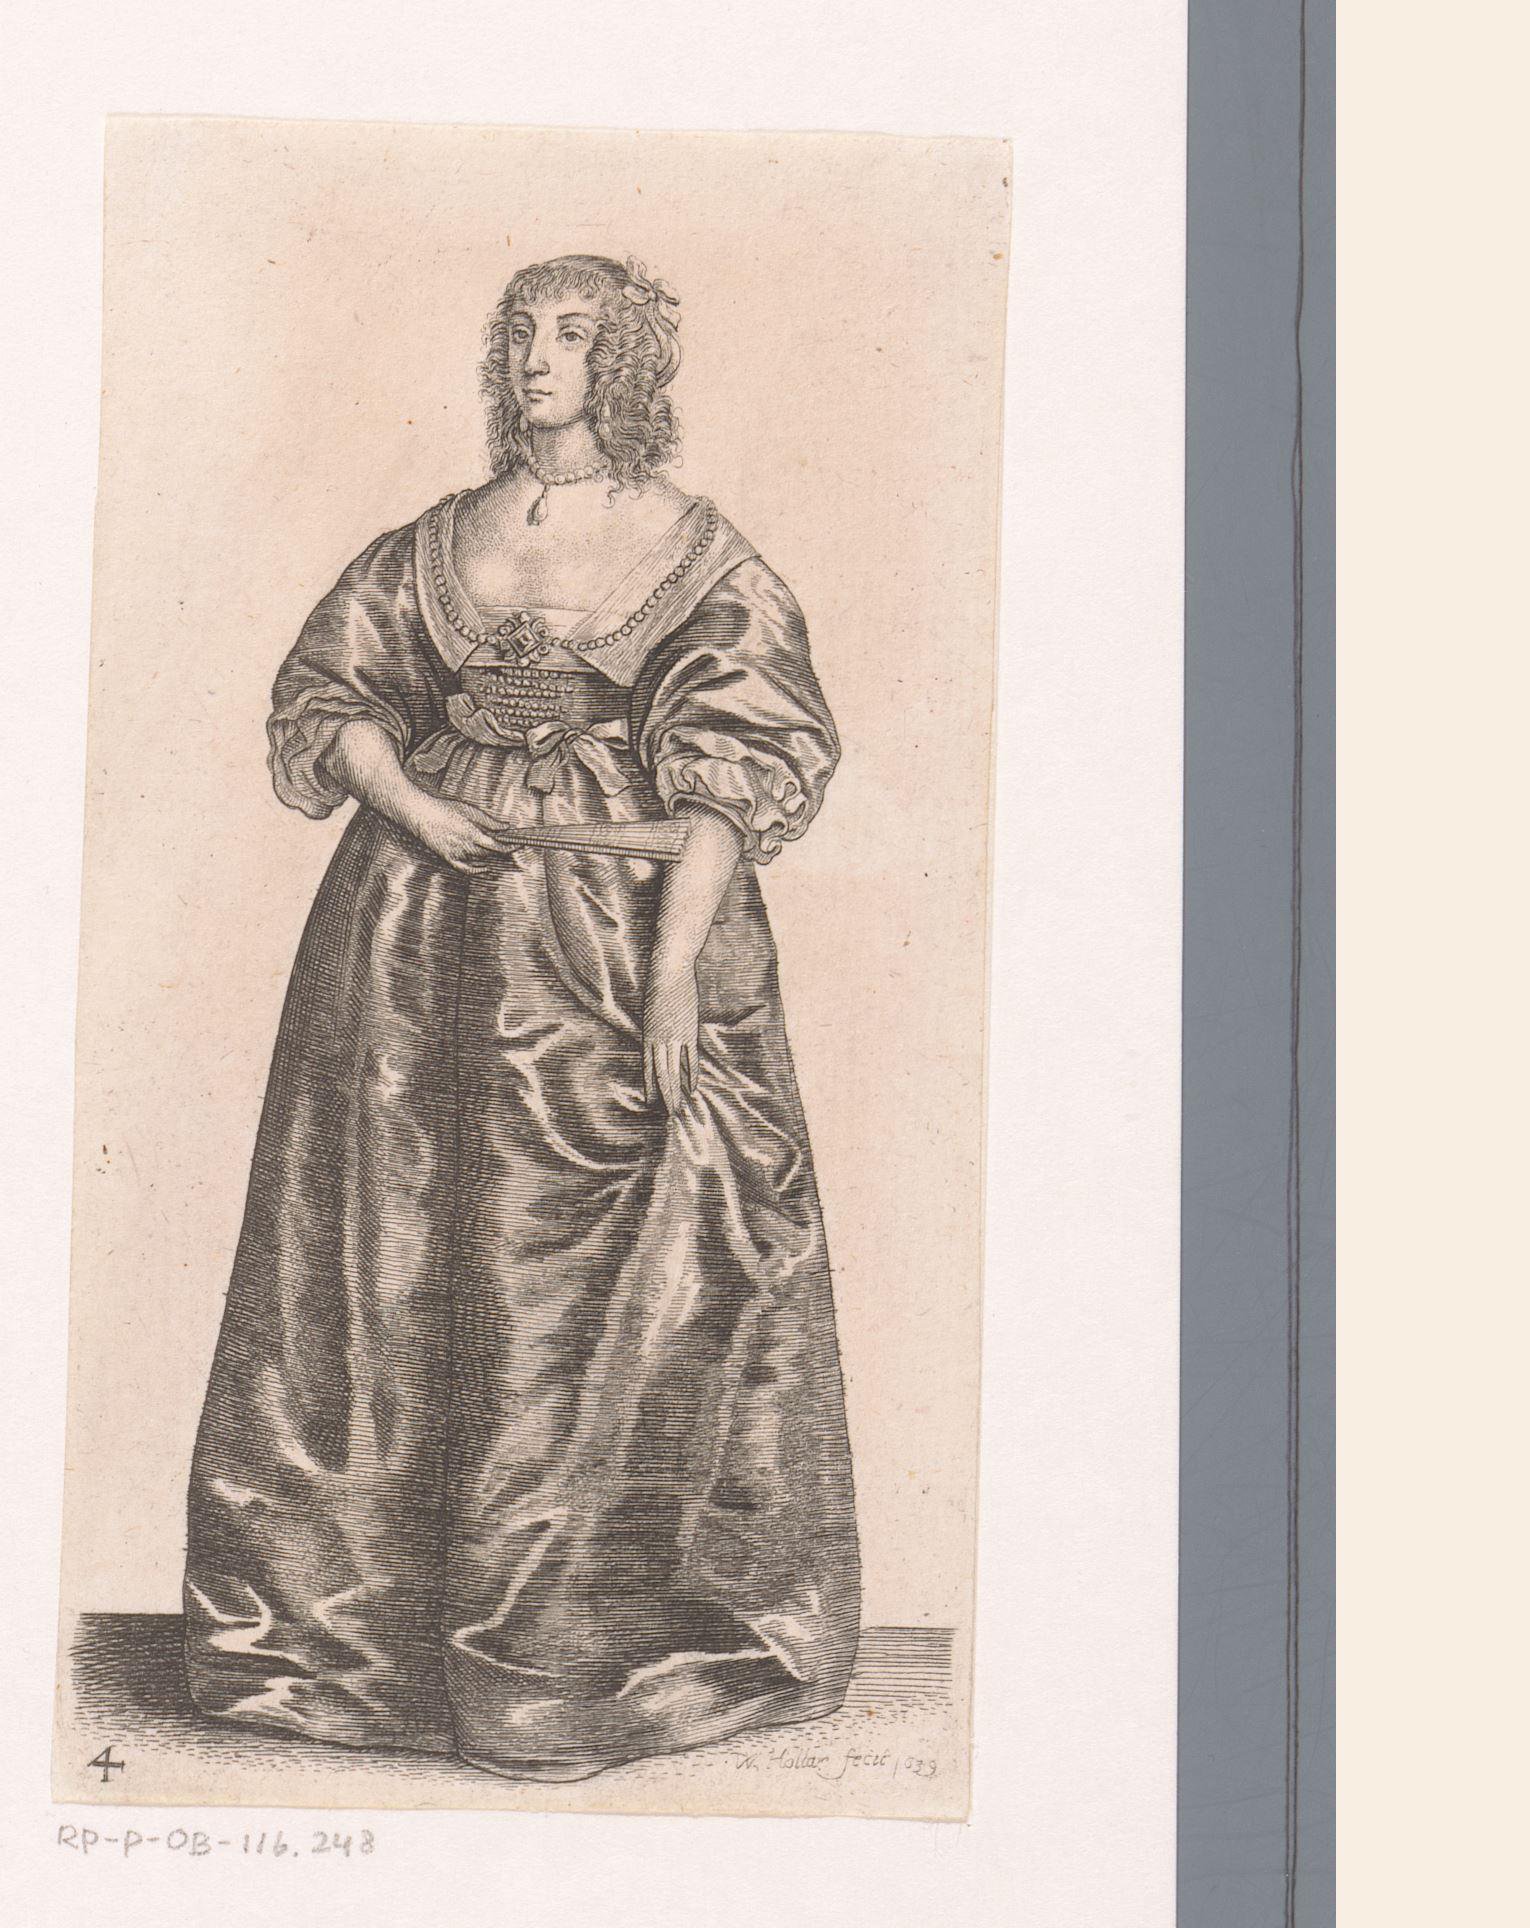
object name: costume print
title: Ornatus Muliebris Anglicanus / The Severall Habits of English Women, from the Nobilitie to the contry woman, they are in these times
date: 1639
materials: paper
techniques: etching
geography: london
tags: ear-rings (+ women's clothes), brooch, agraffe, clasp (+ women's clothes), europeans: englishmen (+ women), styles of hairdress - aa - ~ women, fashion plates, clothes, costume (+ women's clothes), piece of clothing covering the breast or décolleté (+ women's clothes), dress, gown (+ women's clothes), fan, pearl; pearl necklace (+ women's clothes)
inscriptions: collector's mark: Lugt 2228, collector's mark: Lugt 2760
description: Engelse vrouw gekleed in een japon. Parelketting met juweel om de hals en een parelsnoer bij de boord van haar japon, met een broche bij het decolleté. In de rechterhand een gesloten vouwwaaier, een strik in het gekrulde haar.